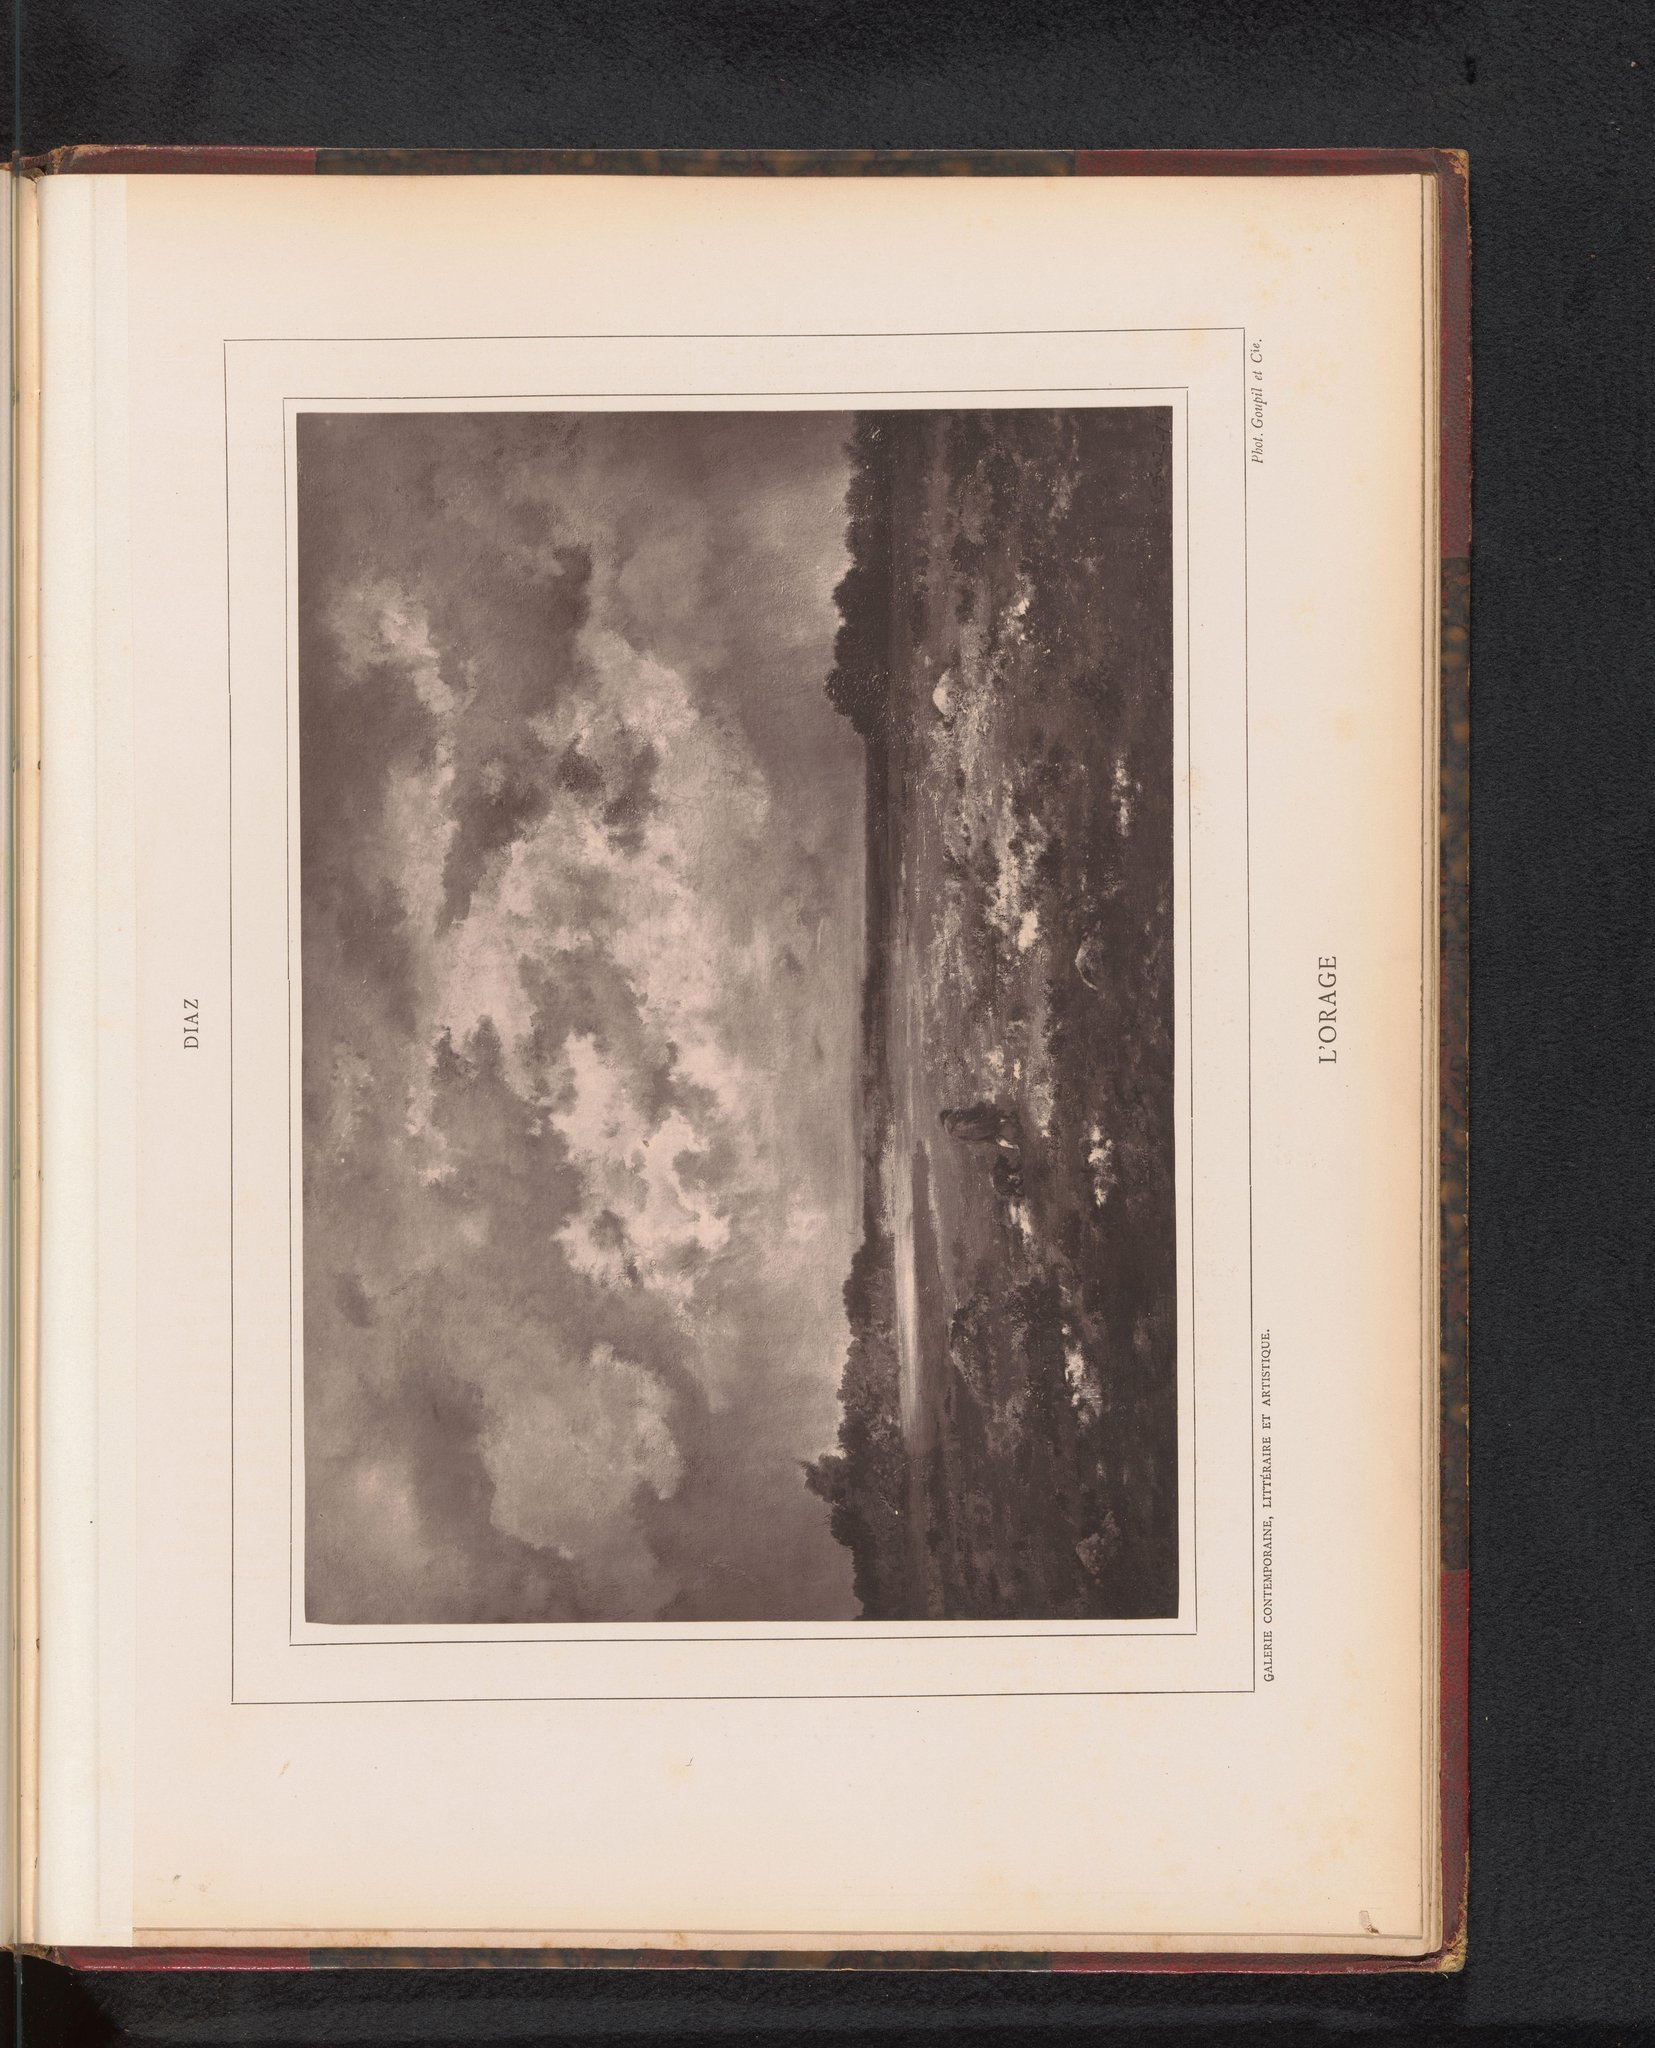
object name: page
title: l'orage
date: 1873-1878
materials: paper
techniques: woodburytype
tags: landscapes (+ landscape with figures, staffage), storm on land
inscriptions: inscription: ‘Galerie Contemporaine, Littéraire et Artistique.’